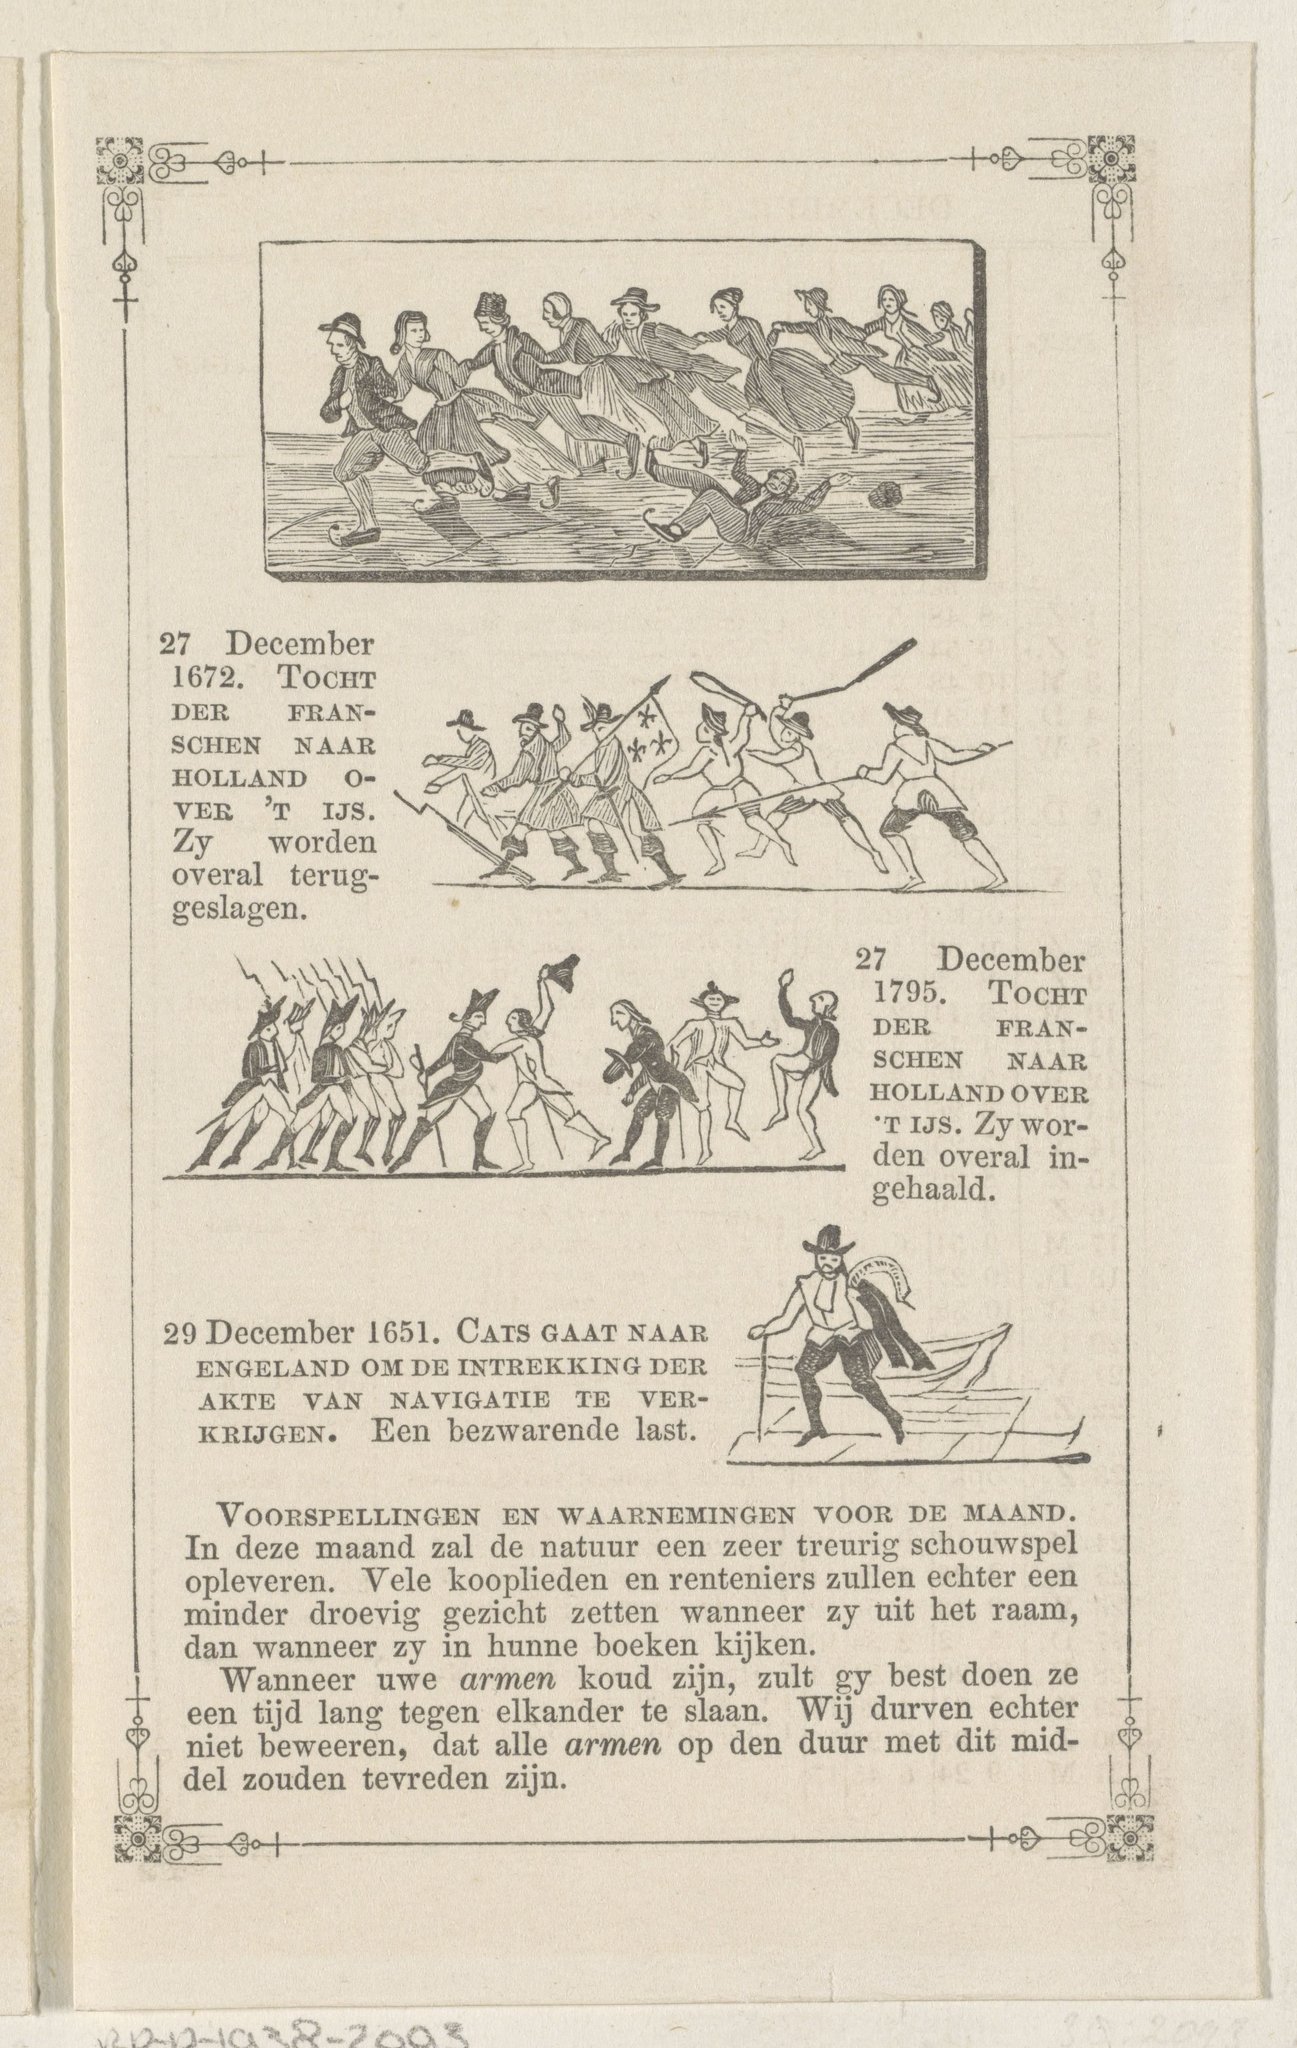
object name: book illustration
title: December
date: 1849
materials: paper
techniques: letterpress printing, engraving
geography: netherlands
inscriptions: collector's mark: Lugt 2760, collector's mark: Lugt 2228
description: Midden boven een voorstelling van figuren schaatsend op het ijs. Daaronder een aantal voorstellingen van gebeurtenissen die plaatsvonden in de maand december, waaronder de tocht van de Fransen naar Nederland over het ijs in 1672 en in 1795. Midden onder voorspellingen en waarnemeningen voor de maand december in 1849.